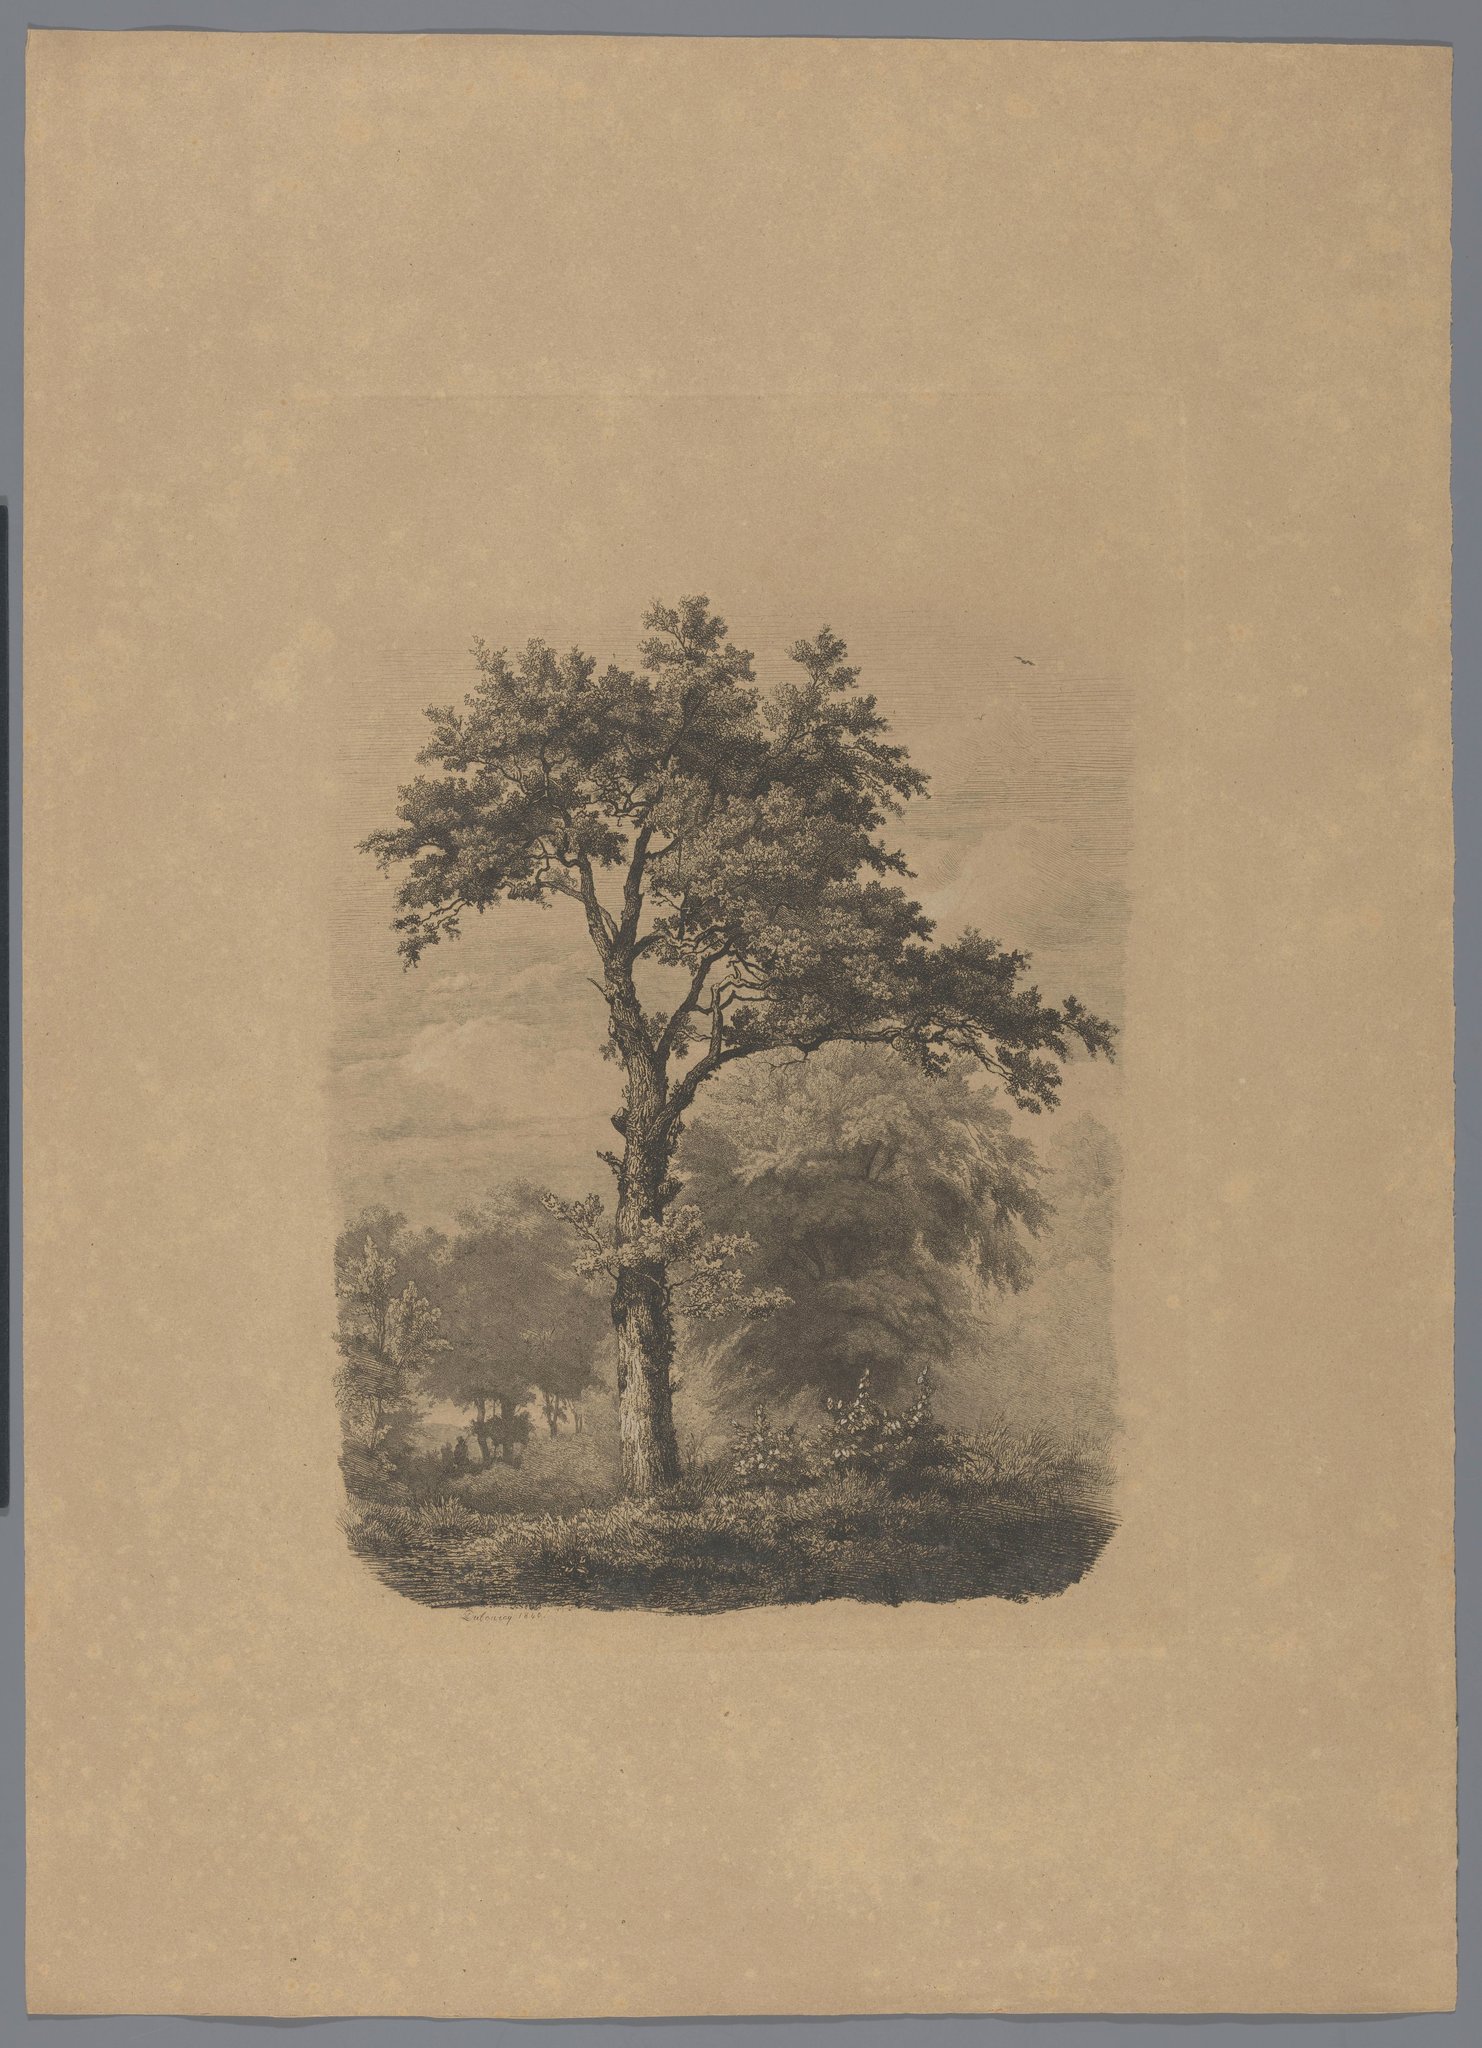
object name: print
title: Vrijstaande loofboom in landschap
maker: pierre louis dubourcq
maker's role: draughtsman, painter, print maker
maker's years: 1815-1873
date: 1840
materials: paper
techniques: brush, etching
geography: netherlands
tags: trees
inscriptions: collector's mark: Lugt 2228